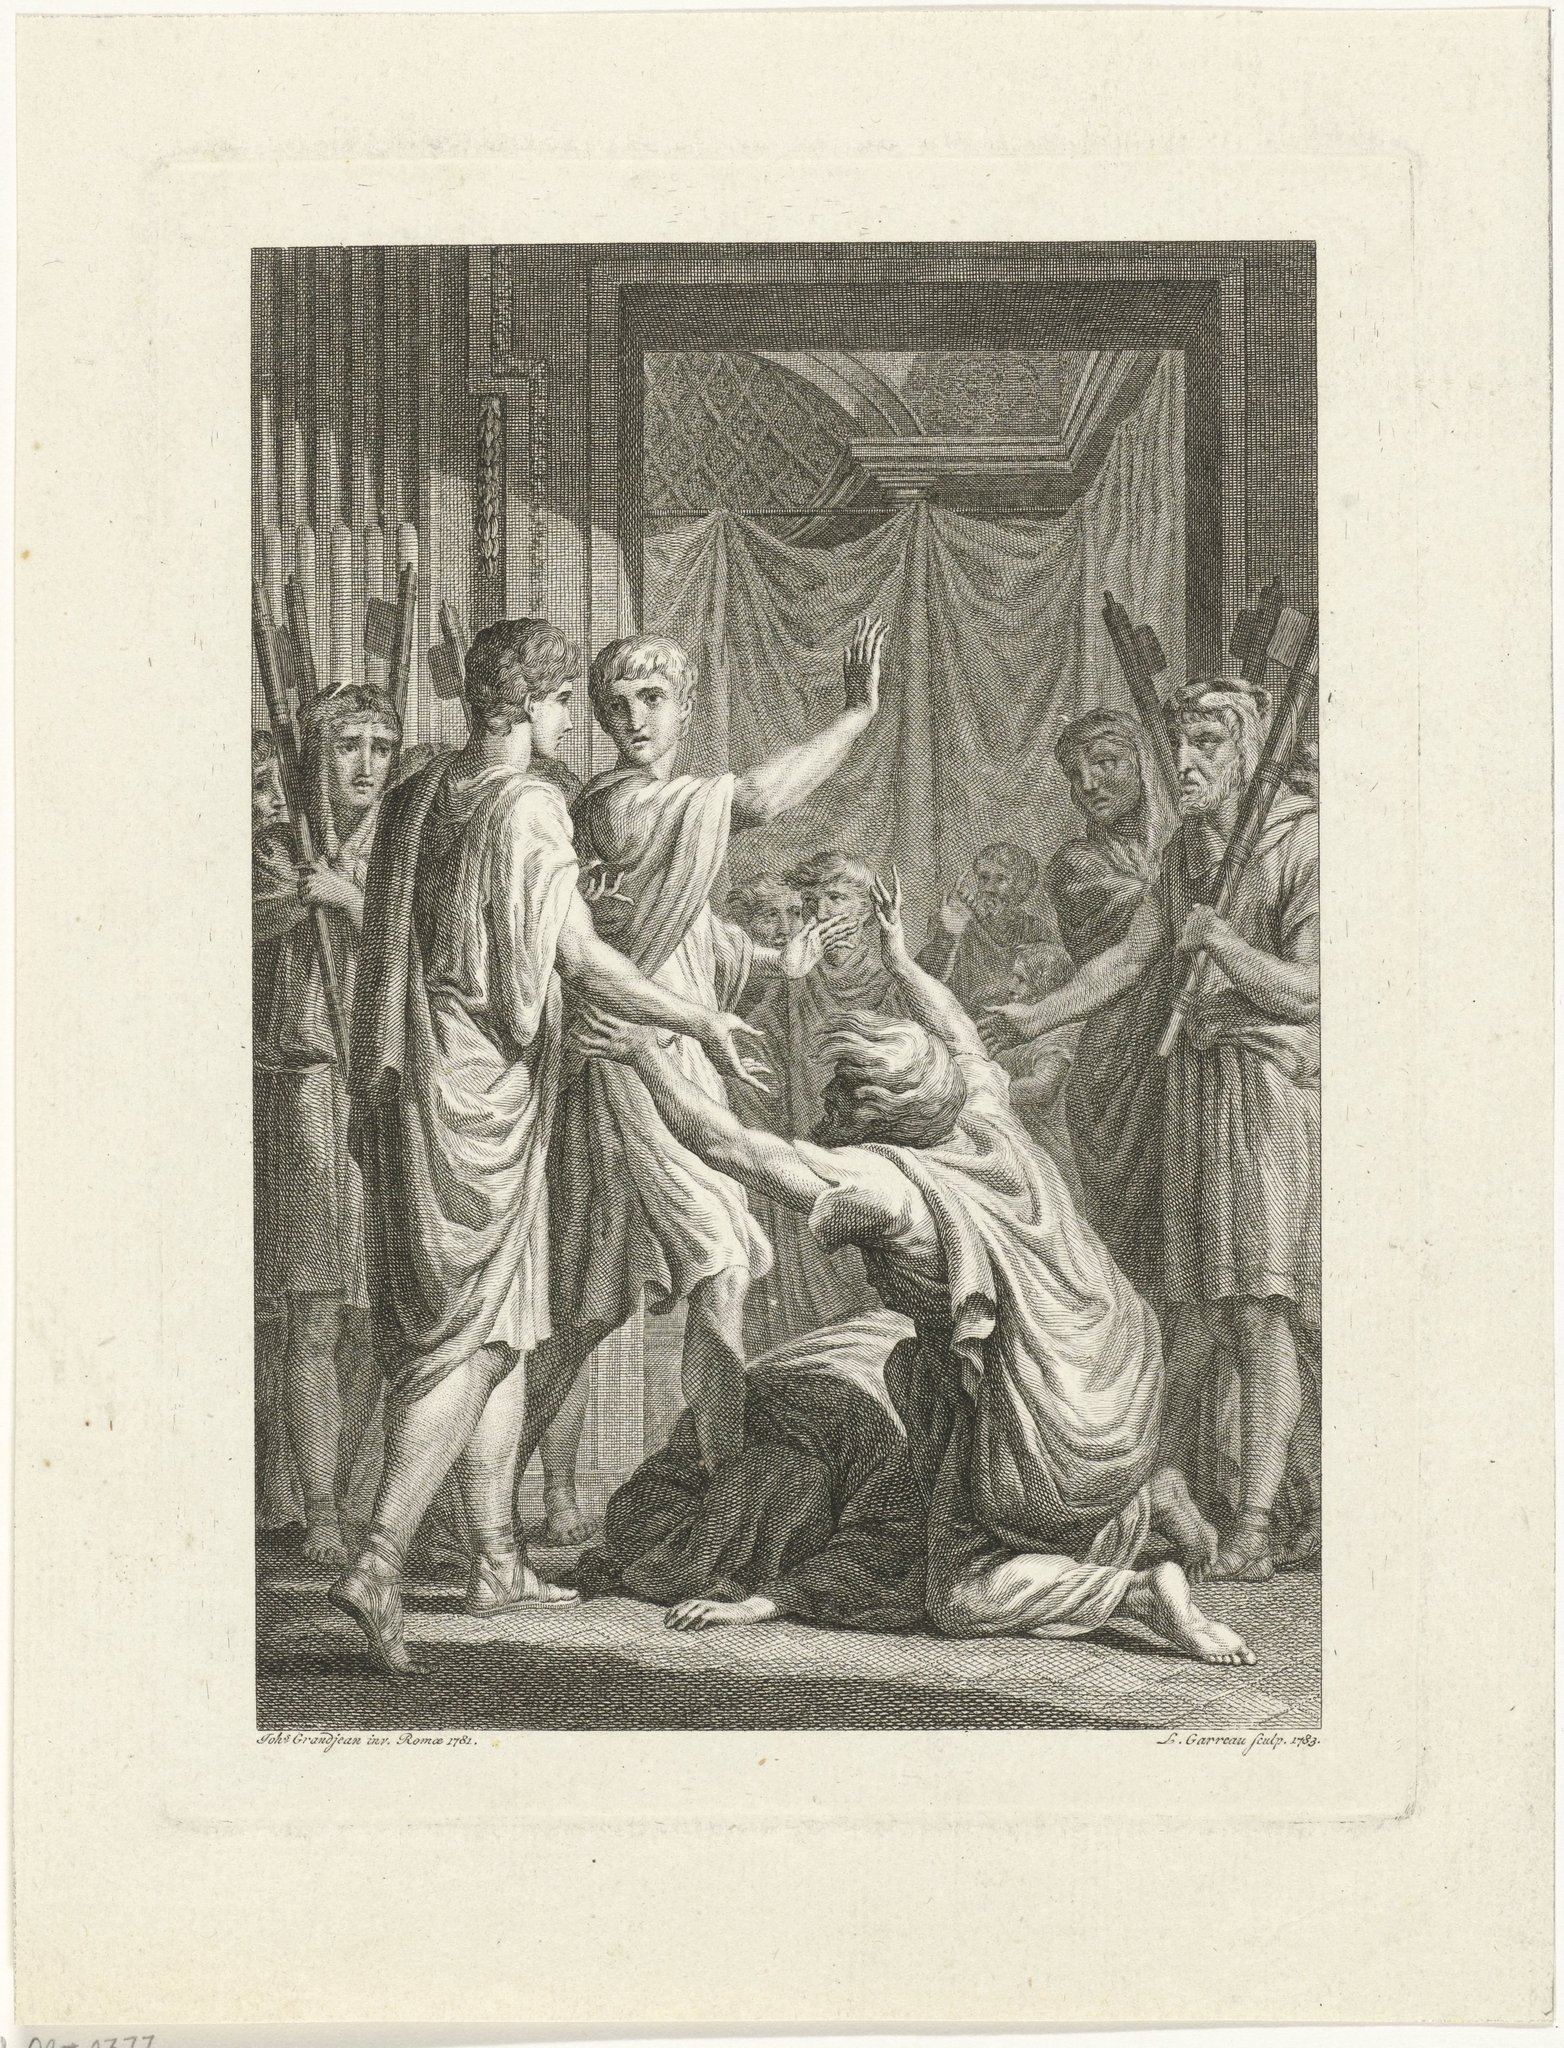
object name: print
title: Twee Germanen knielen voor Germanicus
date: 1783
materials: paper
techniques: engraving, etching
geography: amsterdam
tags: father-love, kneeling on both knees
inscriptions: collector's mark: Lugt 2228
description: Twee Germaanse vaders knielen voor Germanicus en zijn entourage. Ze smeken de veldheer medelijden te hebben met hun zonen, die Germanicus gevangen heeft tijdens zijn laatste veldslag. De prent is een deel van de geschiedenis van generaal Germanicus.